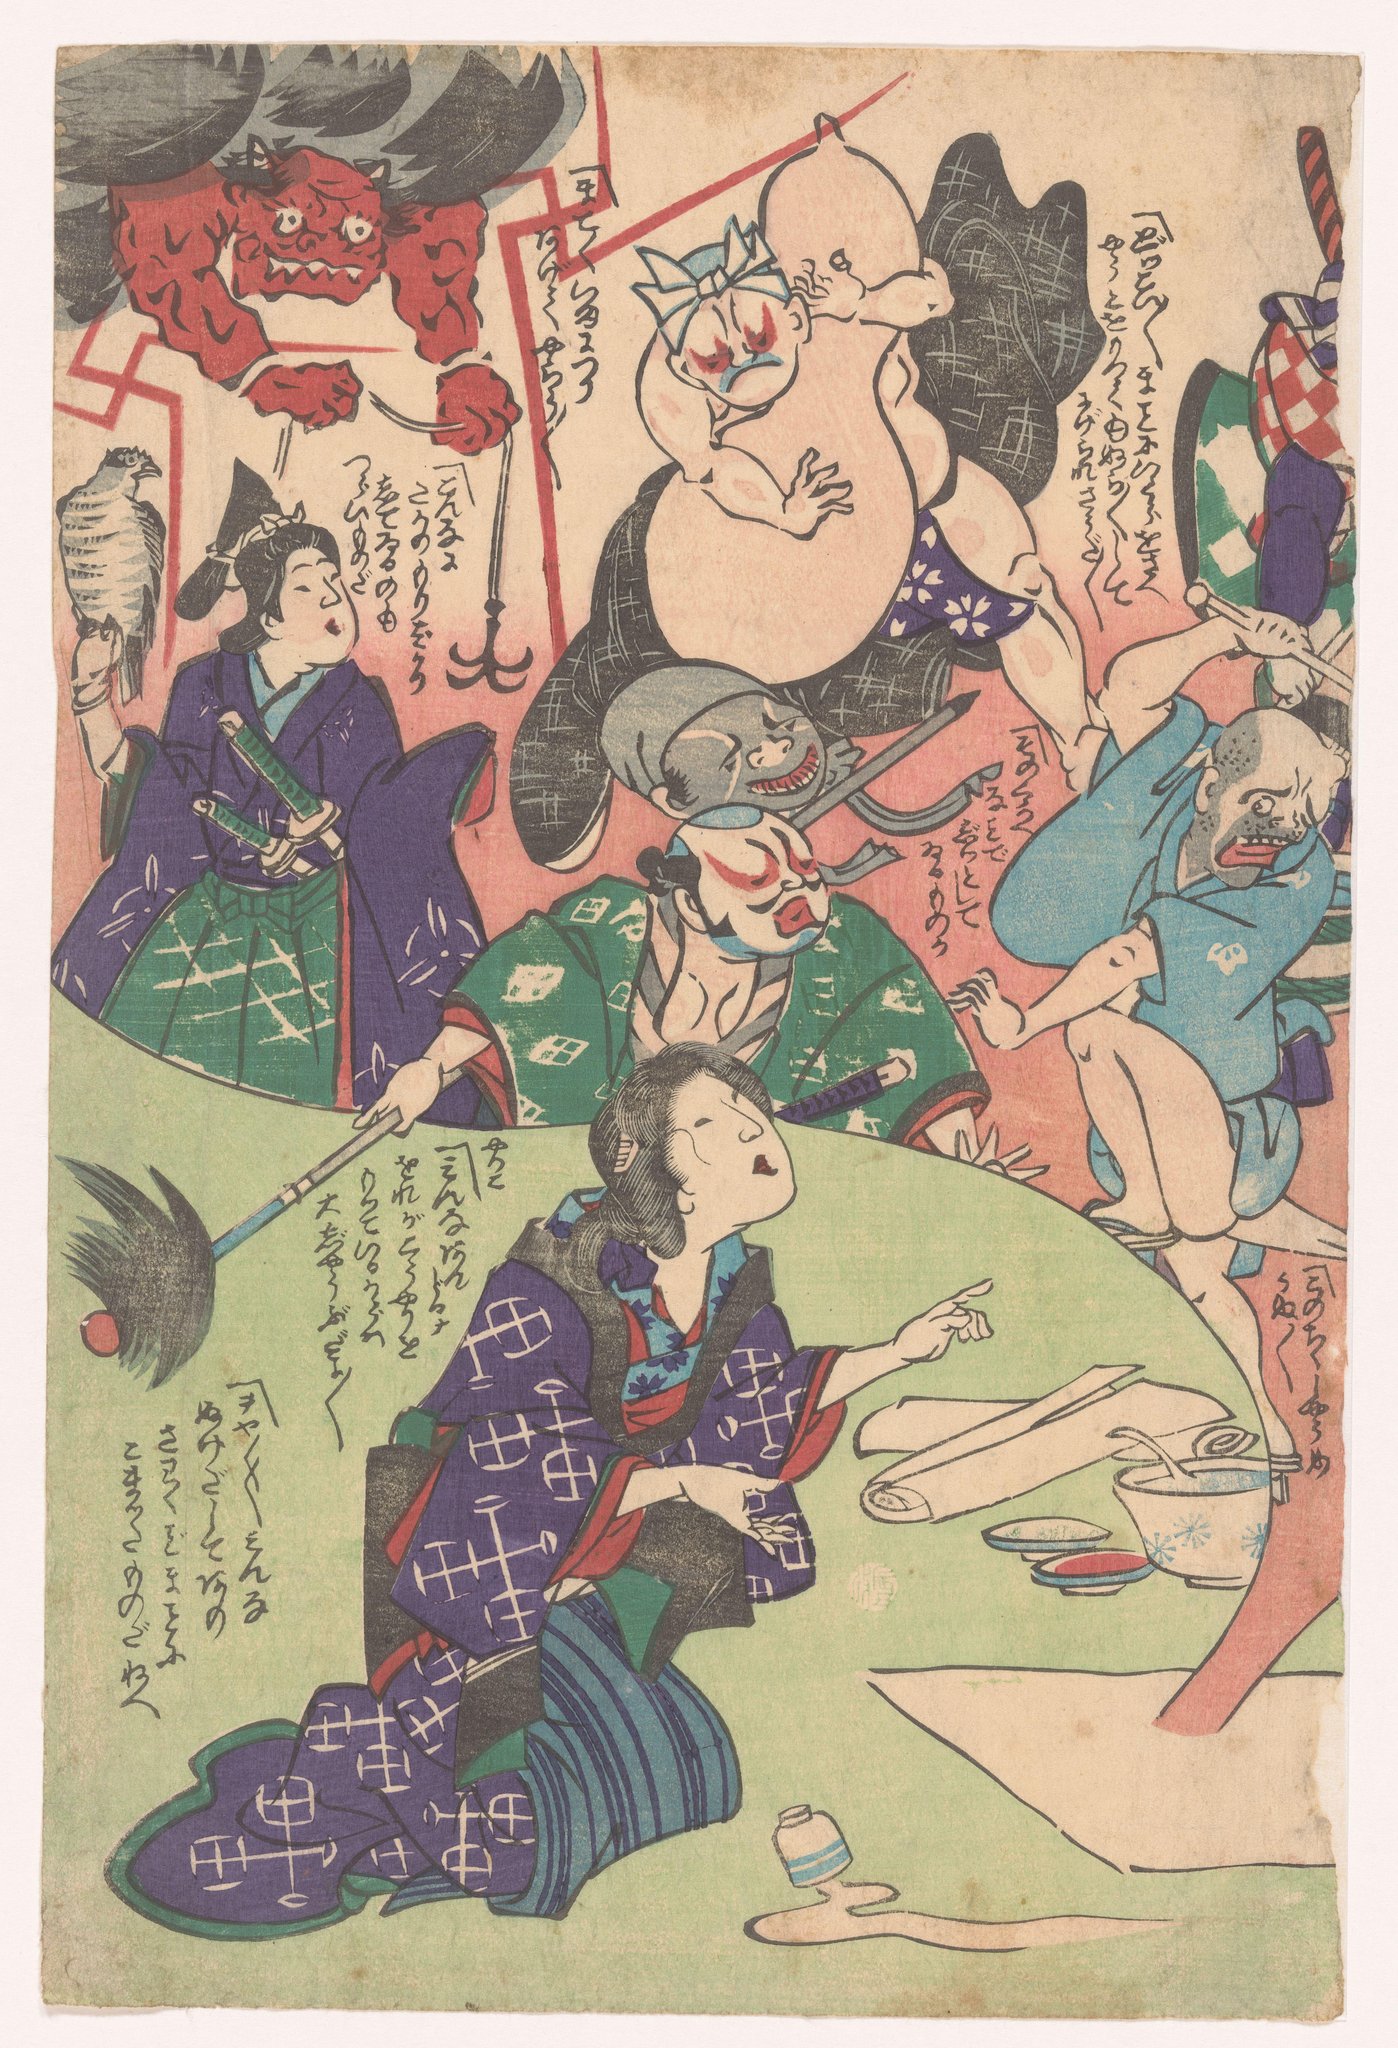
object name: print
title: Otsu-e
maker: utagawa kuniyoshi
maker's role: draughtsman, print maker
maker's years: 1798-1861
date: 1860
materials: paper, ink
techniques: woodcut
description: Een Japanse vrouw knielt voor papier waaruit figuren oprijzen en tot leven komen. Deel van triptiek Otsu-e verhaal.